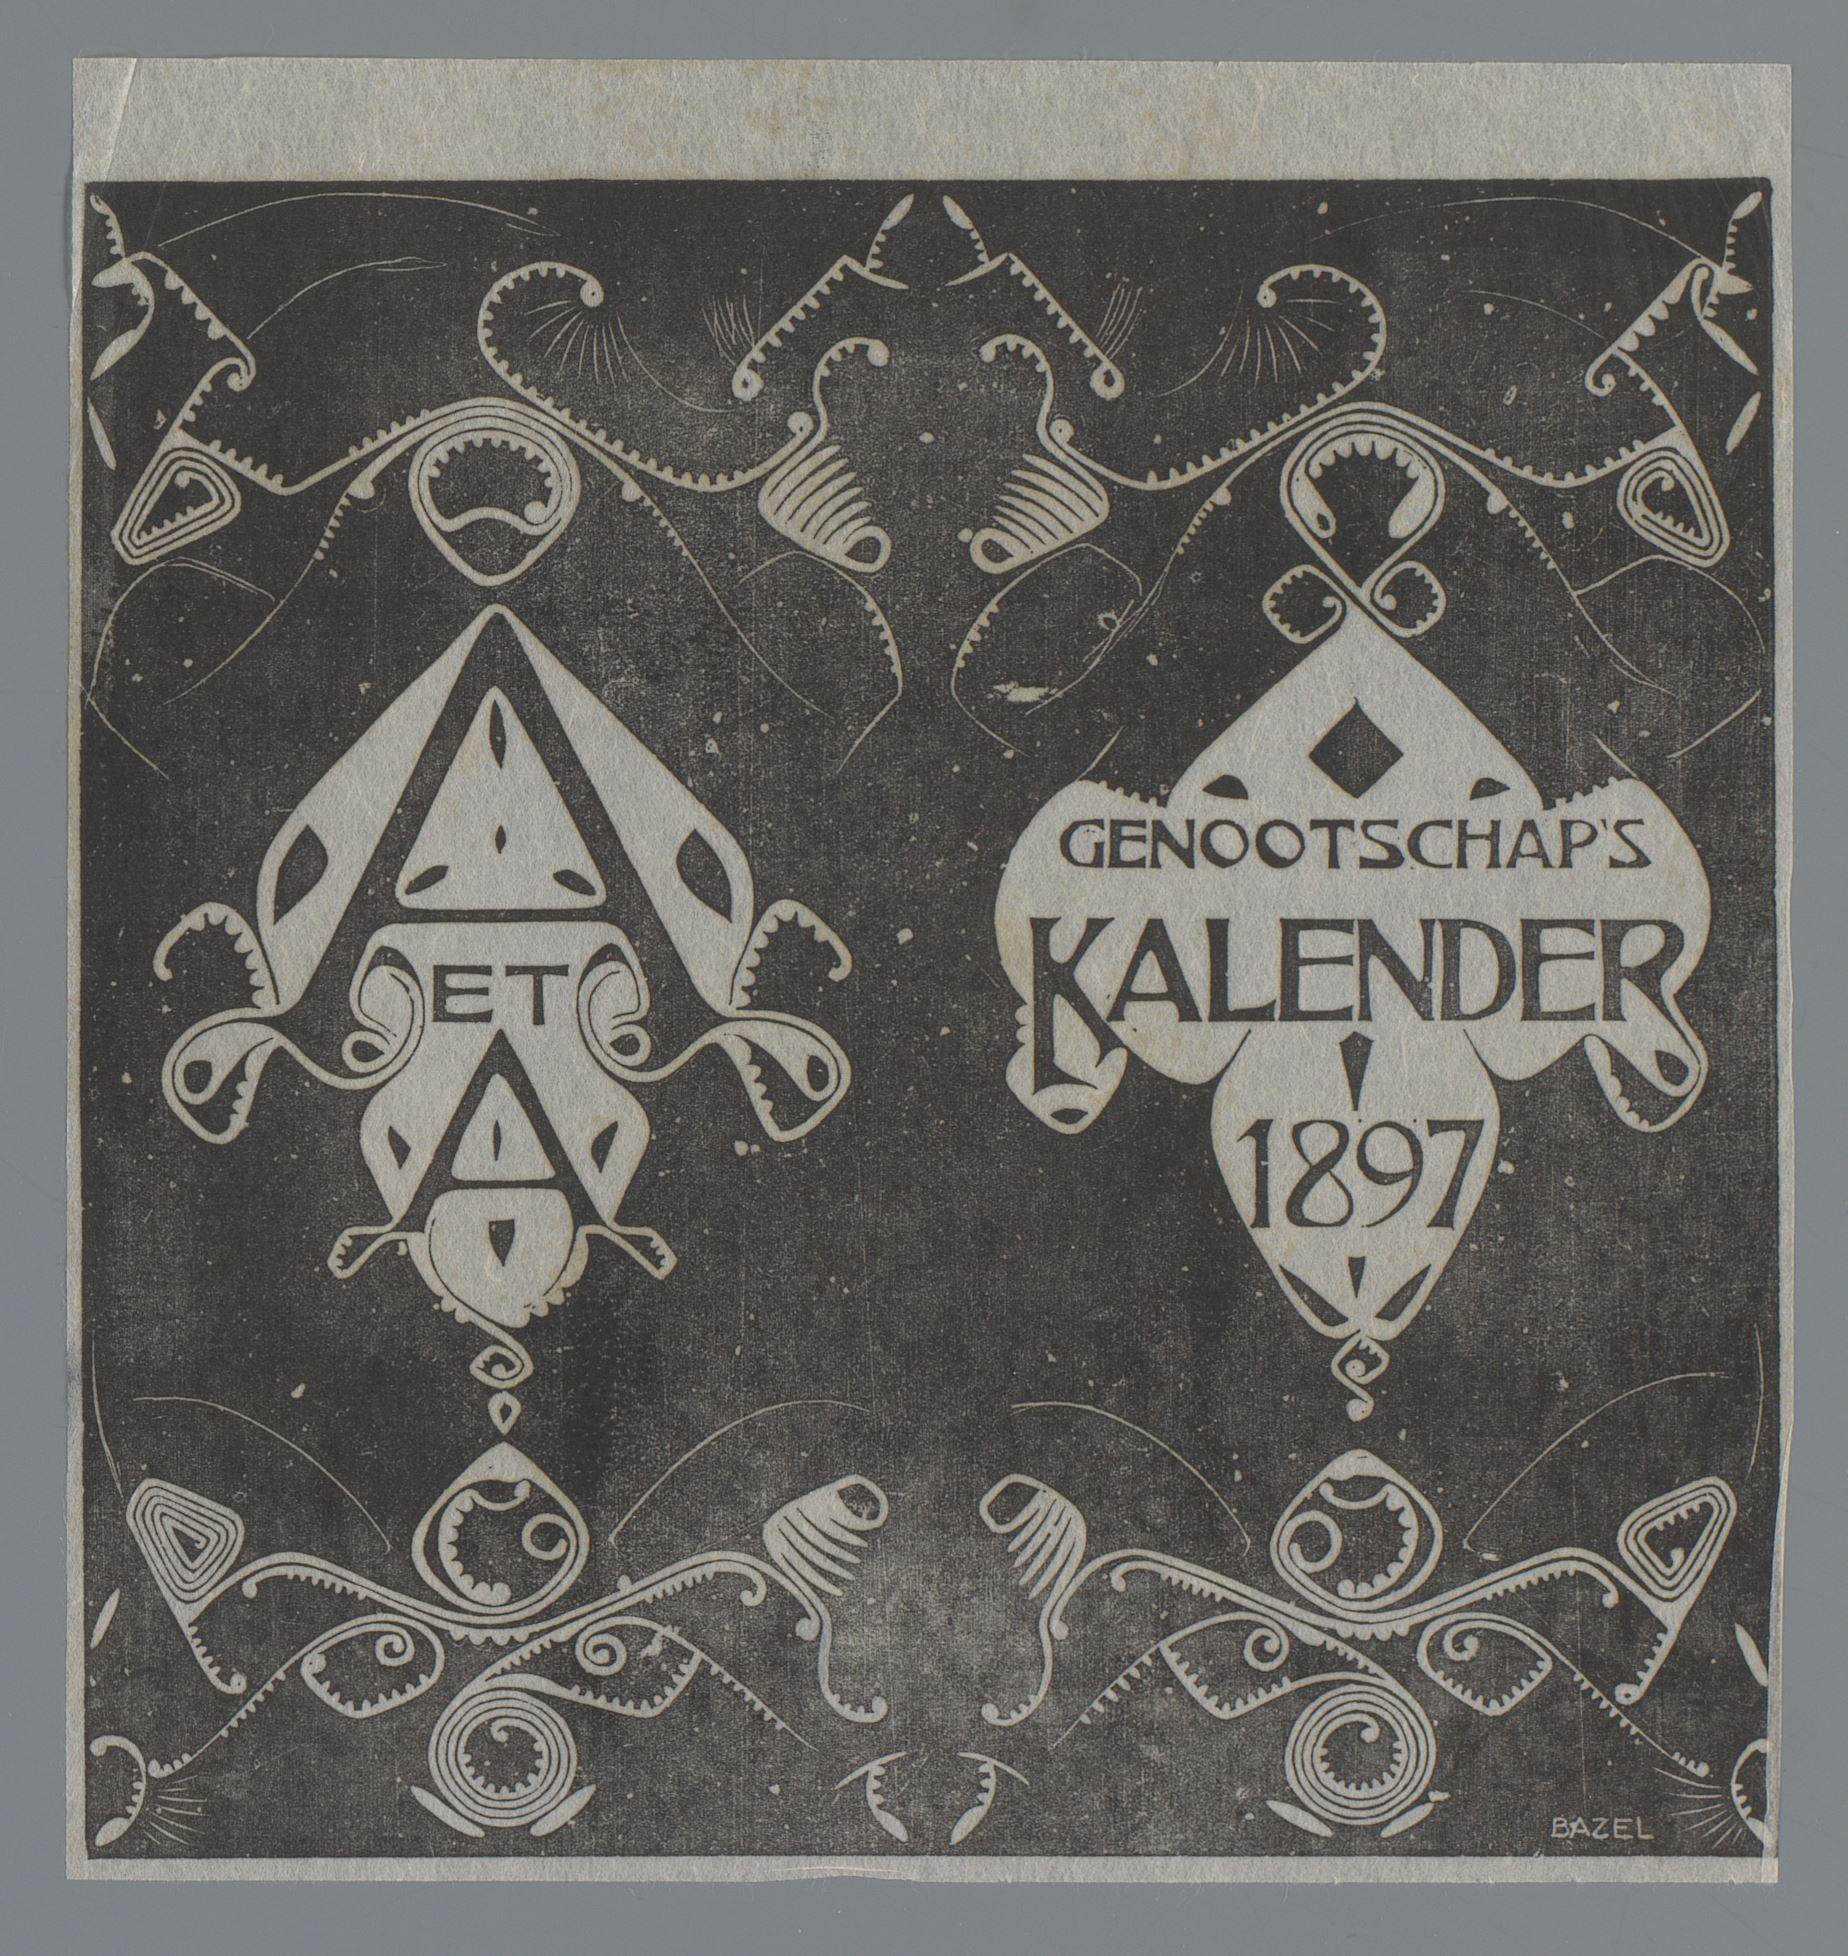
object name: wrapper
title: Omslag voor: Genootschaps kalender 1897, Achitectura et Amicitia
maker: karel petrus cornelis de bazel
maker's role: draughtsman, print maker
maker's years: 1869-1923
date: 1897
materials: paper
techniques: woodcut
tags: book-cover, binding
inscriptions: date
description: Ditzelfde ontwerp is gebruikt voor de kalender van 1898.